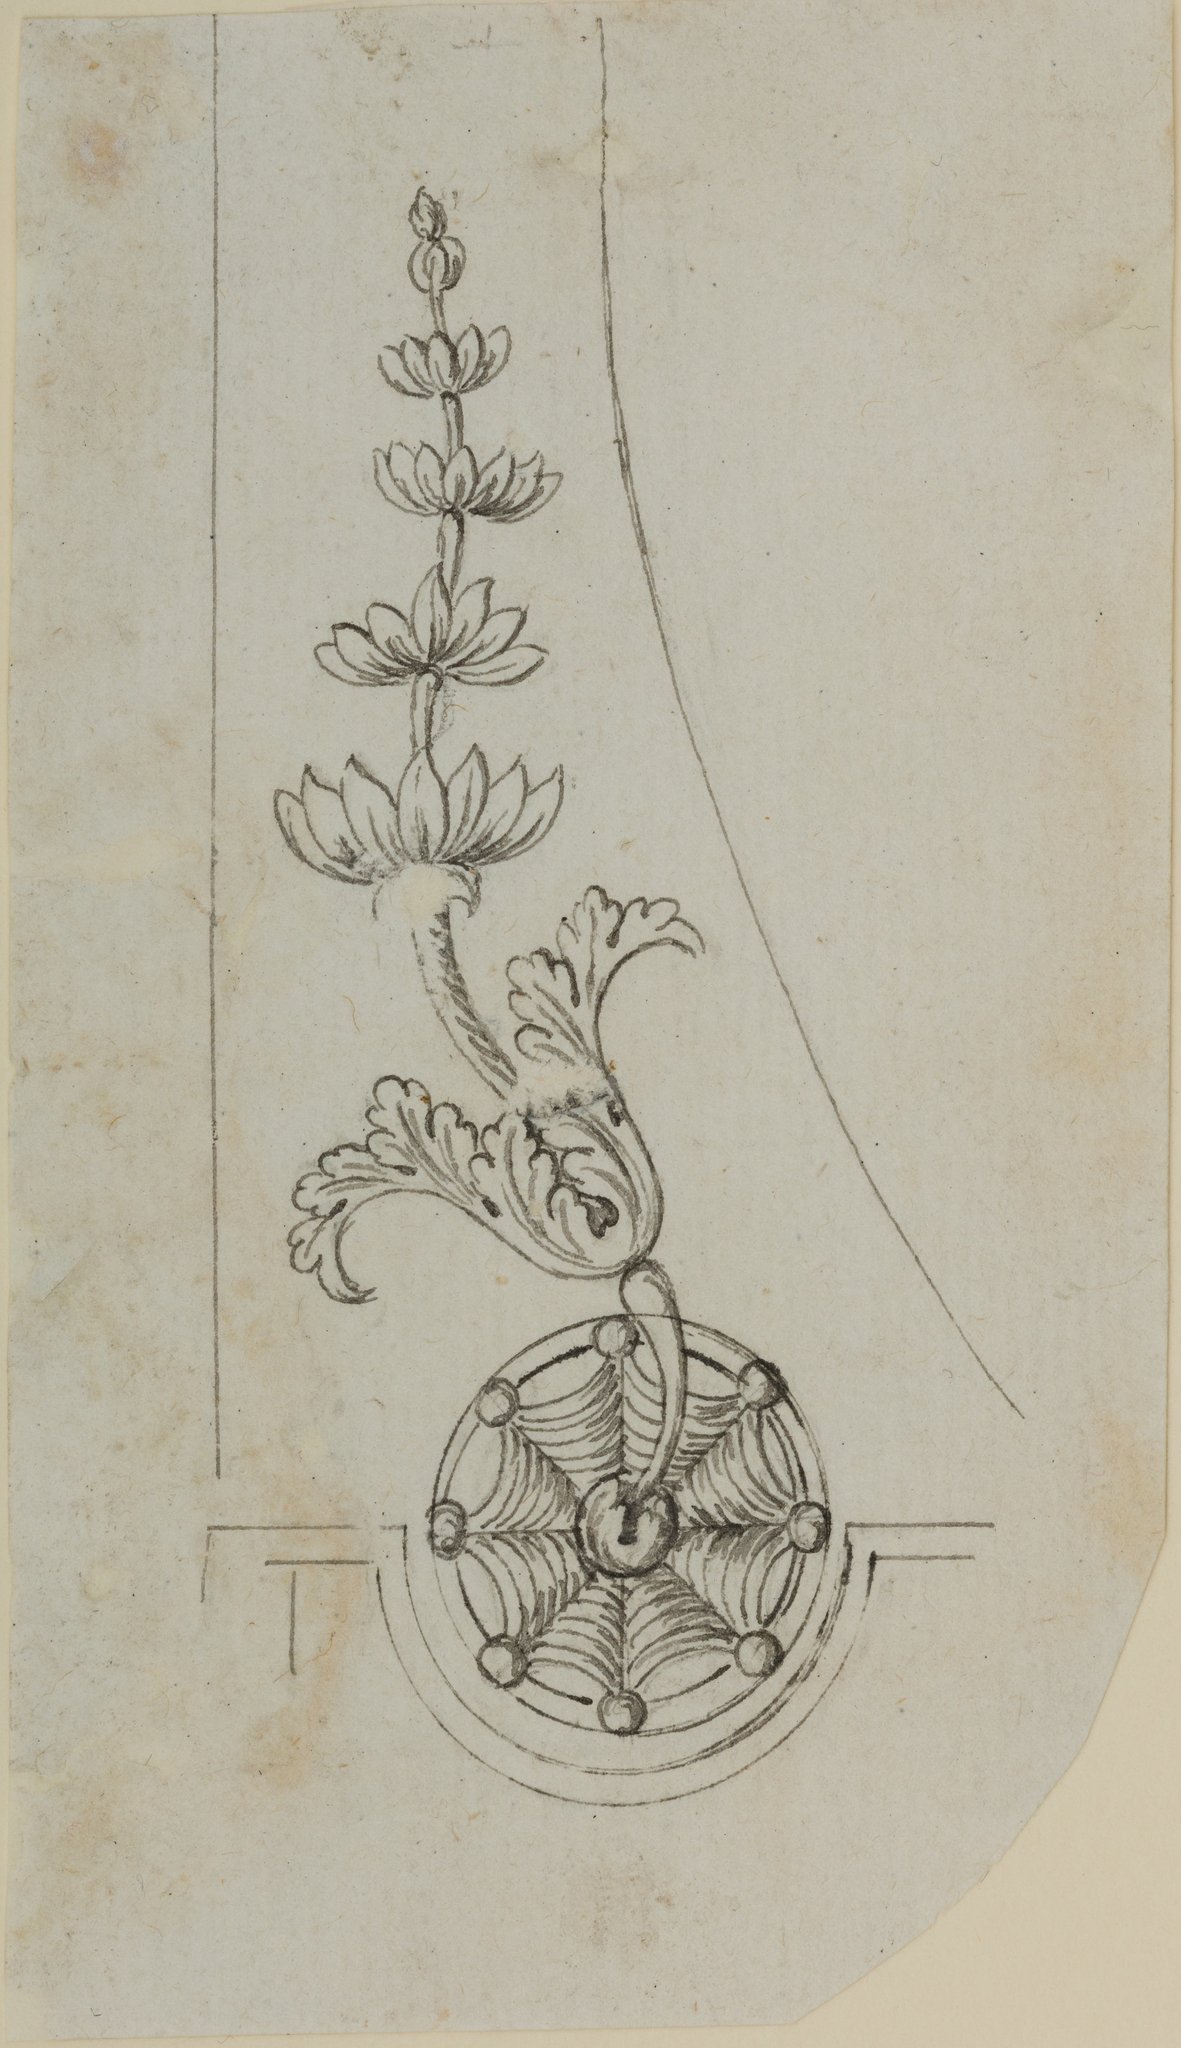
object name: drawing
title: Design for the Decoration of Firearms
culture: french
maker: nicolas noël boutet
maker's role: designer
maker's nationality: french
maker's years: 1761-1833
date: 1797-1805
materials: ink, paper, pencil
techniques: wash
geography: france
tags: plants